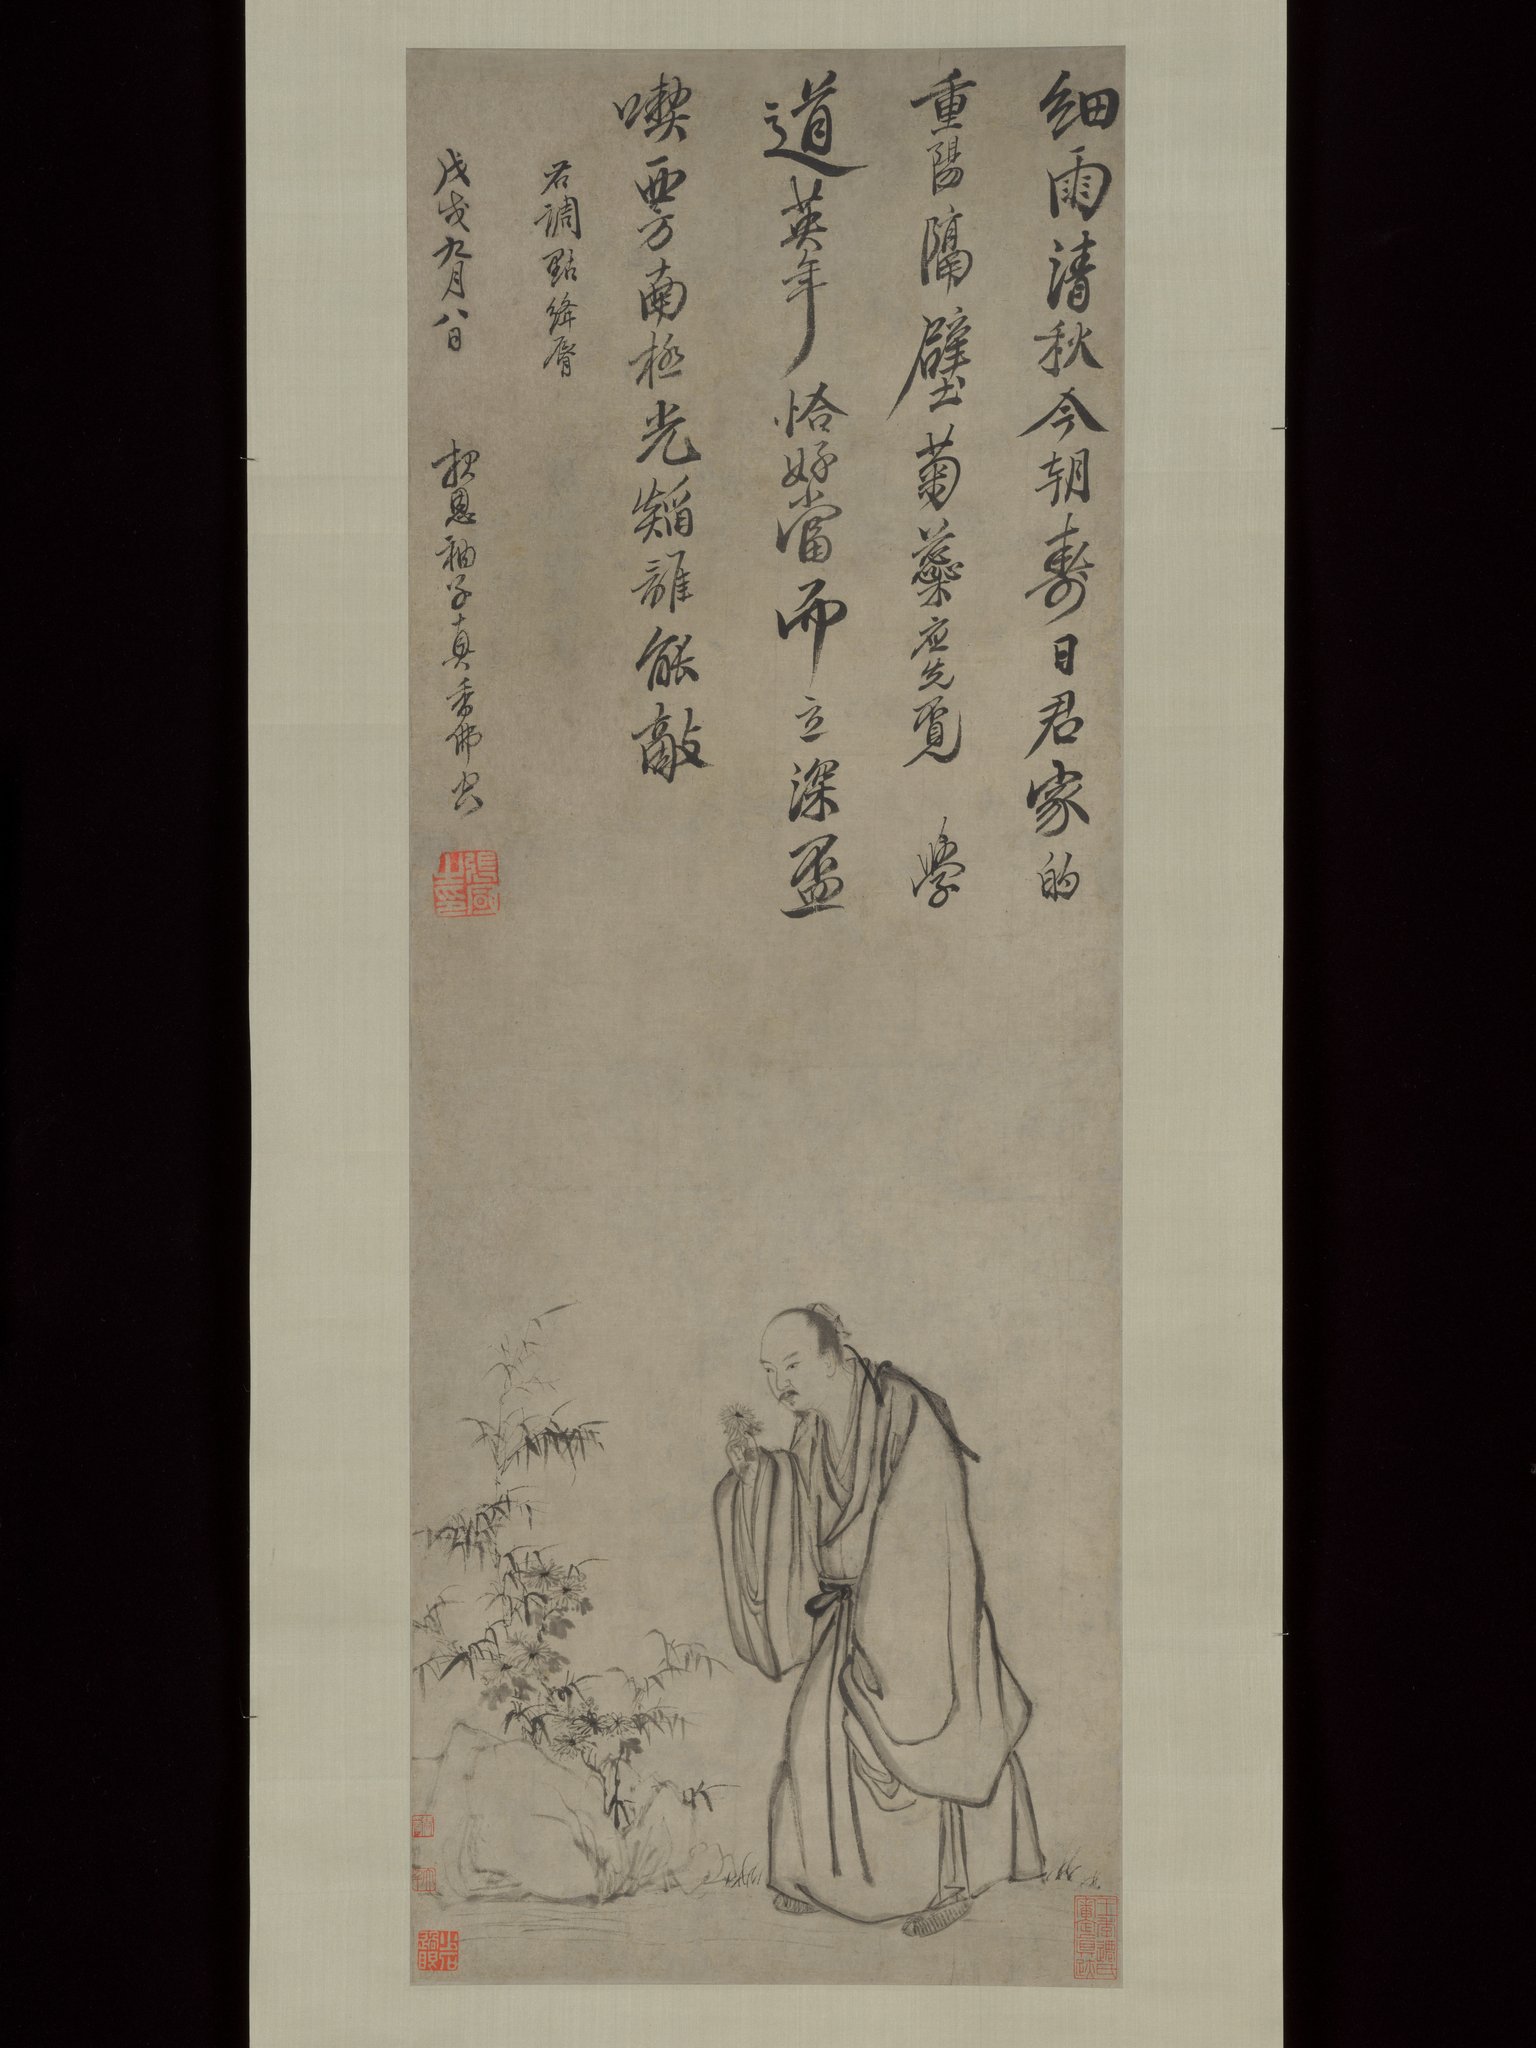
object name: hanging scroll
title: Plucking Chrysanthemums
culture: chinese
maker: zhang feng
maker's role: artist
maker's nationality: chinese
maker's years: 1618-1662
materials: ink, paper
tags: men